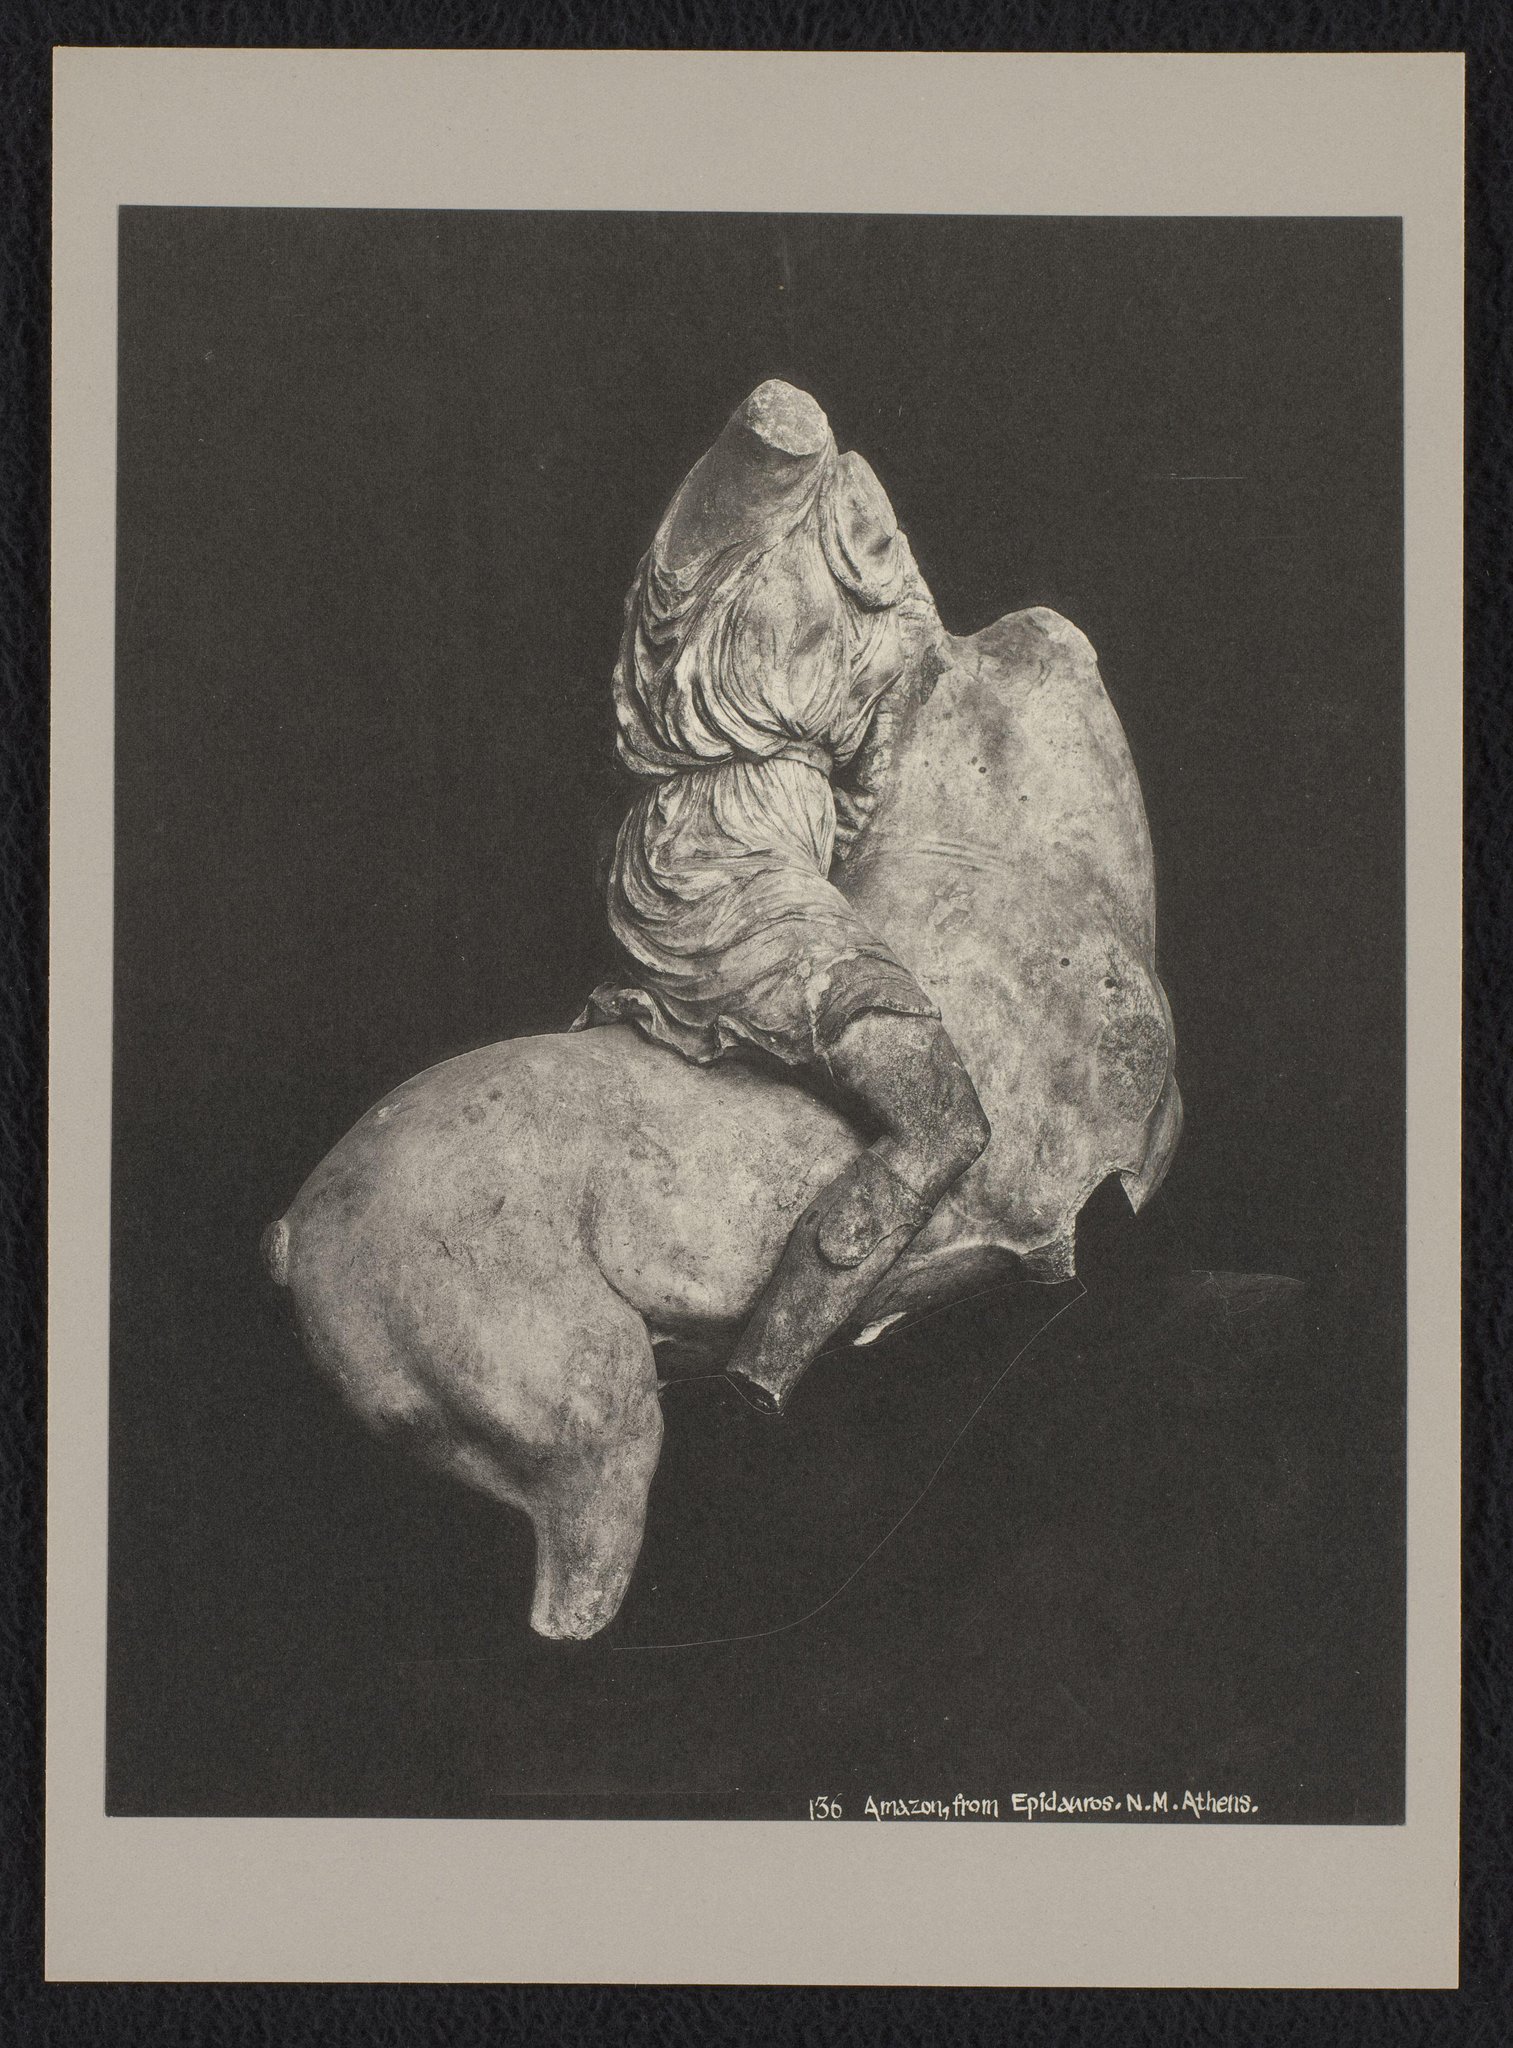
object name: photograph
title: Beeld van amazone van Epidauros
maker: Anonymous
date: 1895-1915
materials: cardboard, paper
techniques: photograph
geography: athens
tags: athene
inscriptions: number: ‘36.’